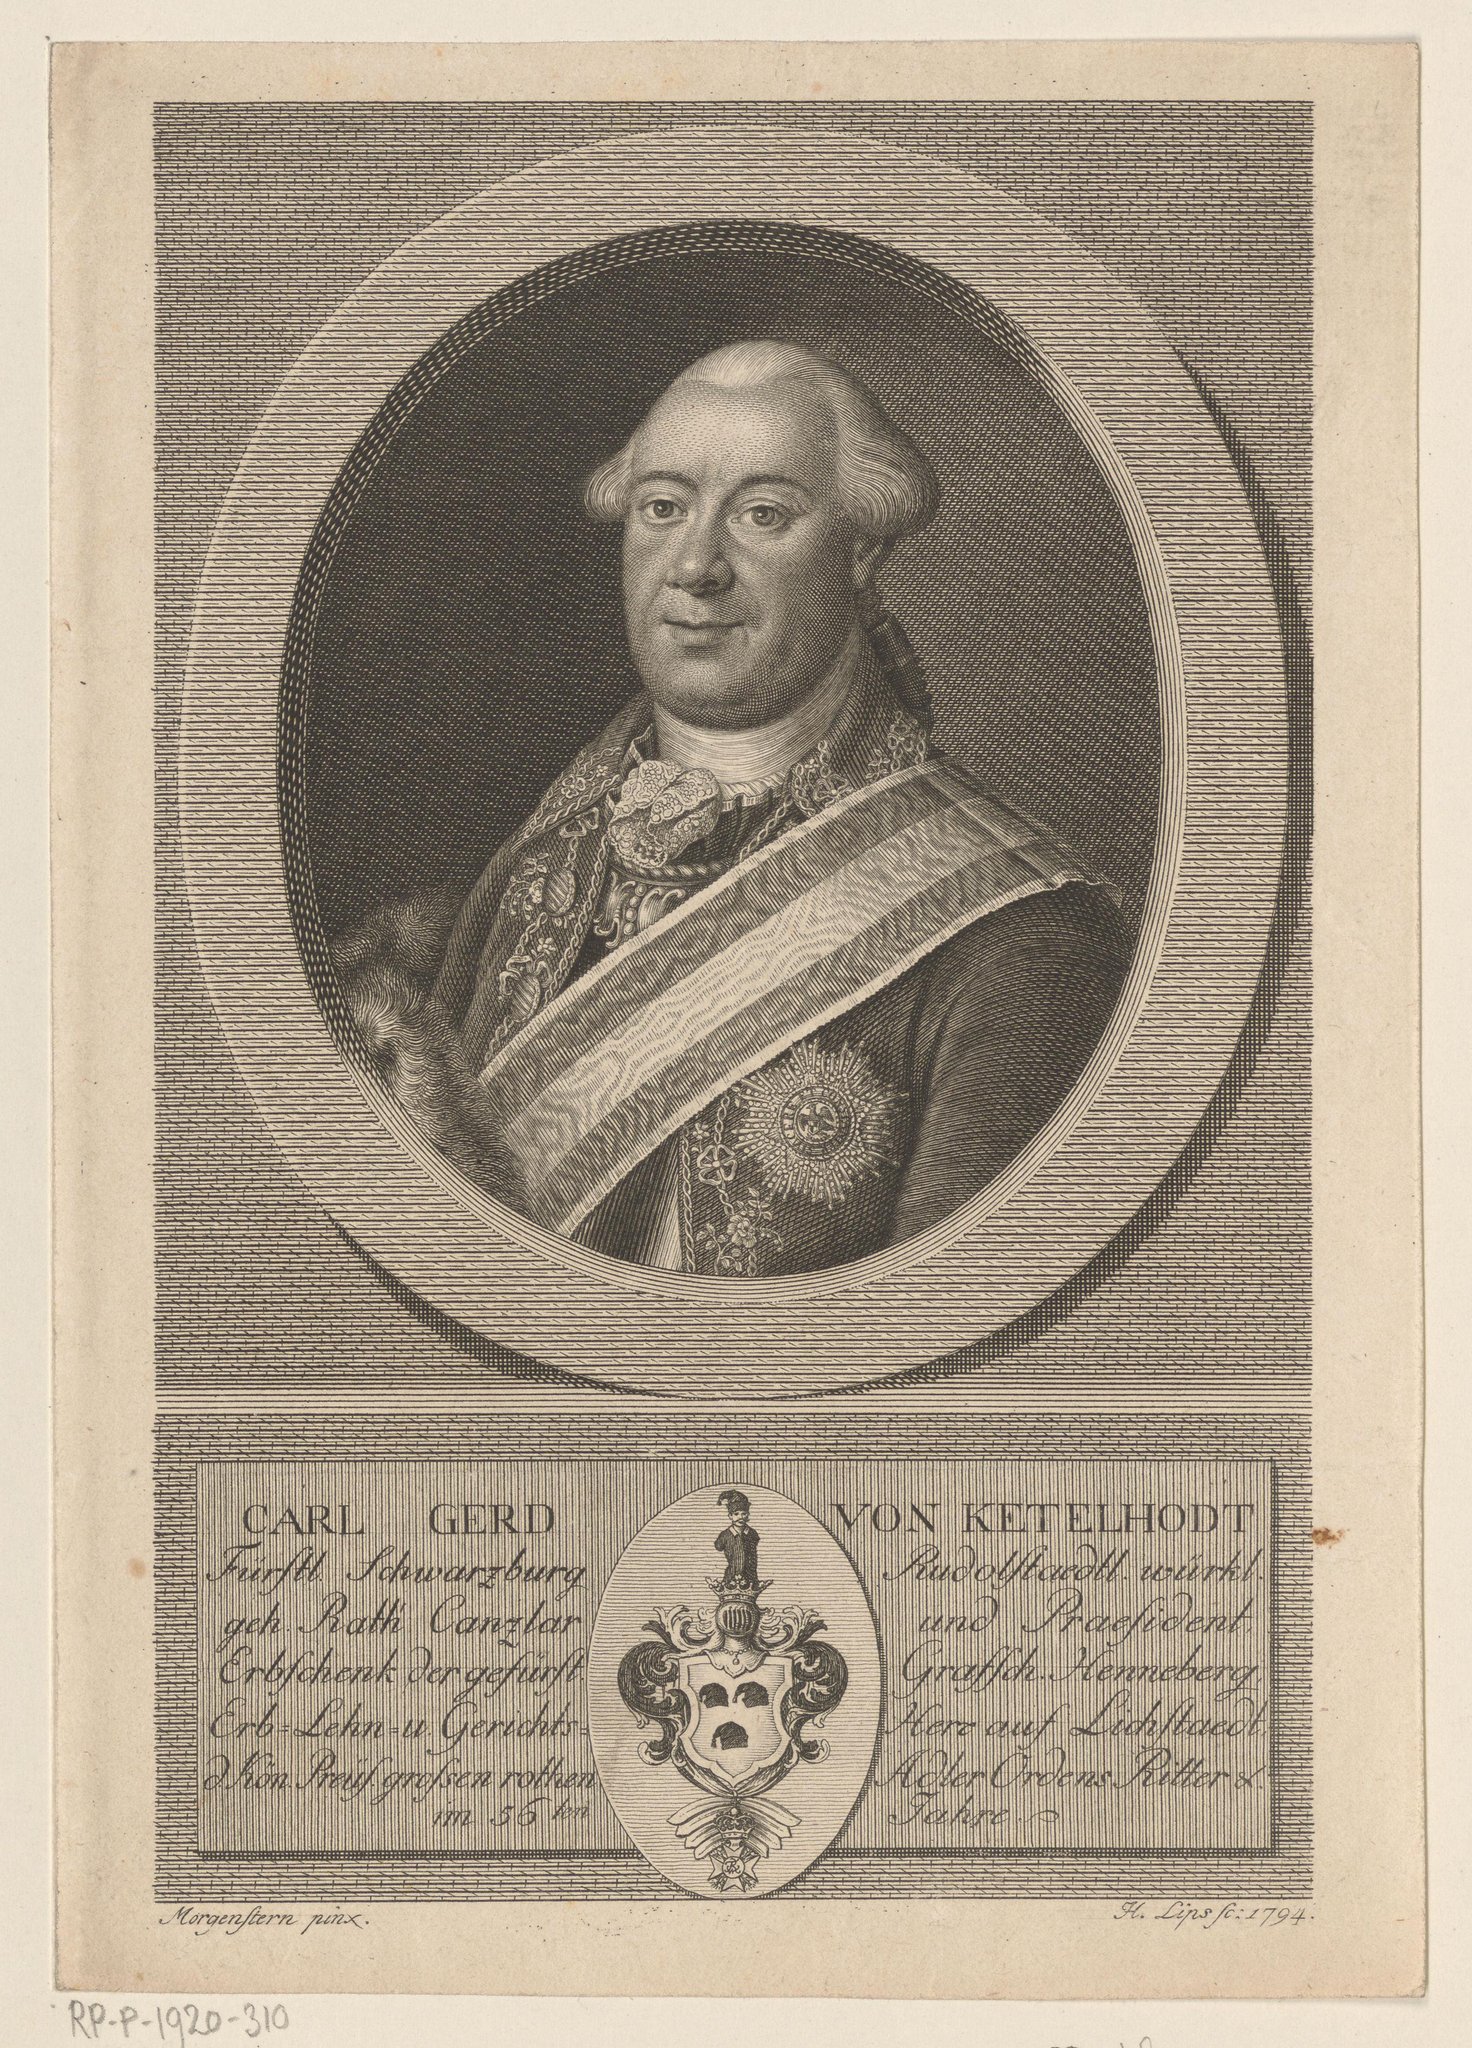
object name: print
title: Portret van Carl Gerd von Ketelhodt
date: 1794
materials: paper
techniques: engraving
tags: historical persons, armorial bearing, heraldry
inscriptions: collector's mark: Lugt 2228